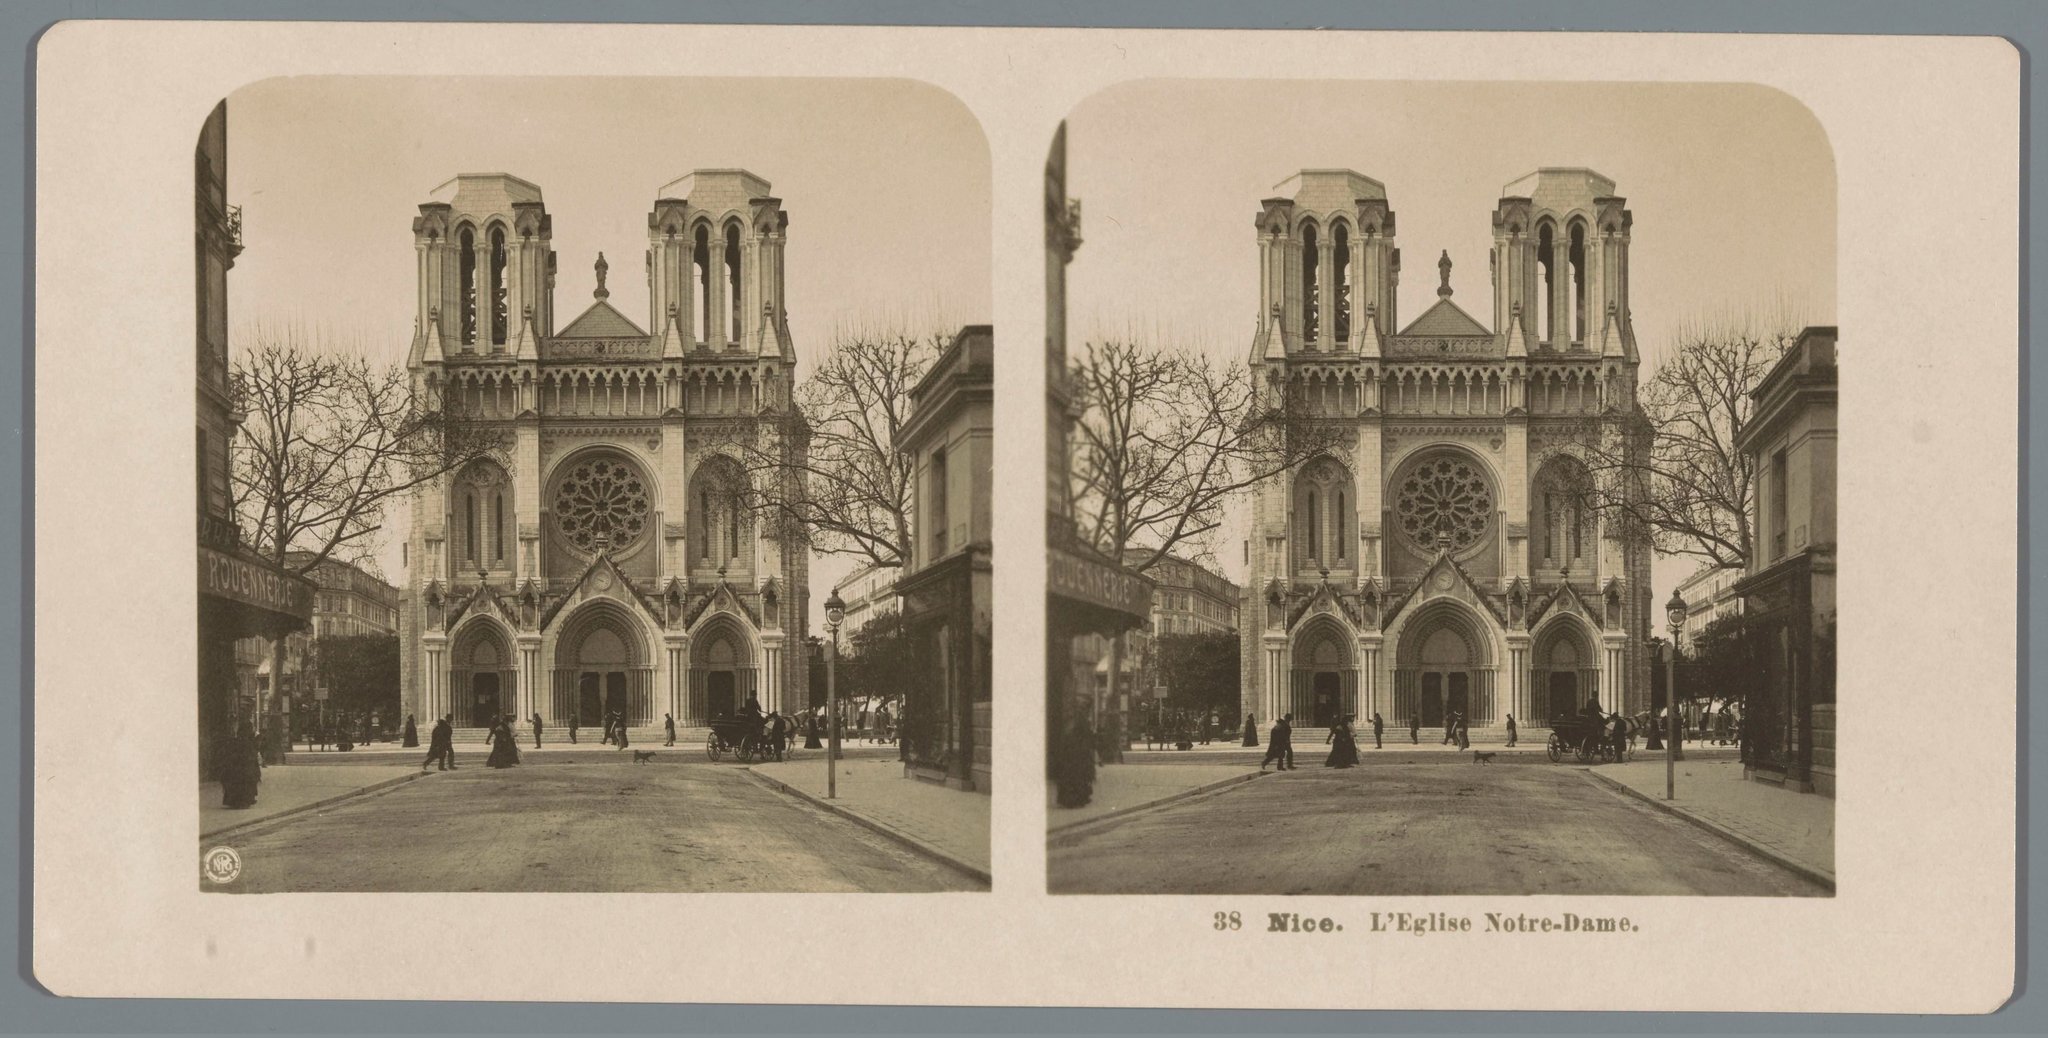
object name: stereograph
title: Voorgevel van de Notre-Dame te Nice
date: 1904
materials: cardboard, photographic support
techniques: gelatin silver print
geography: nice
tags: church (exterior), façade (of house or building)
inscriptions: inscription: ‘NPG’, number: ‘38’